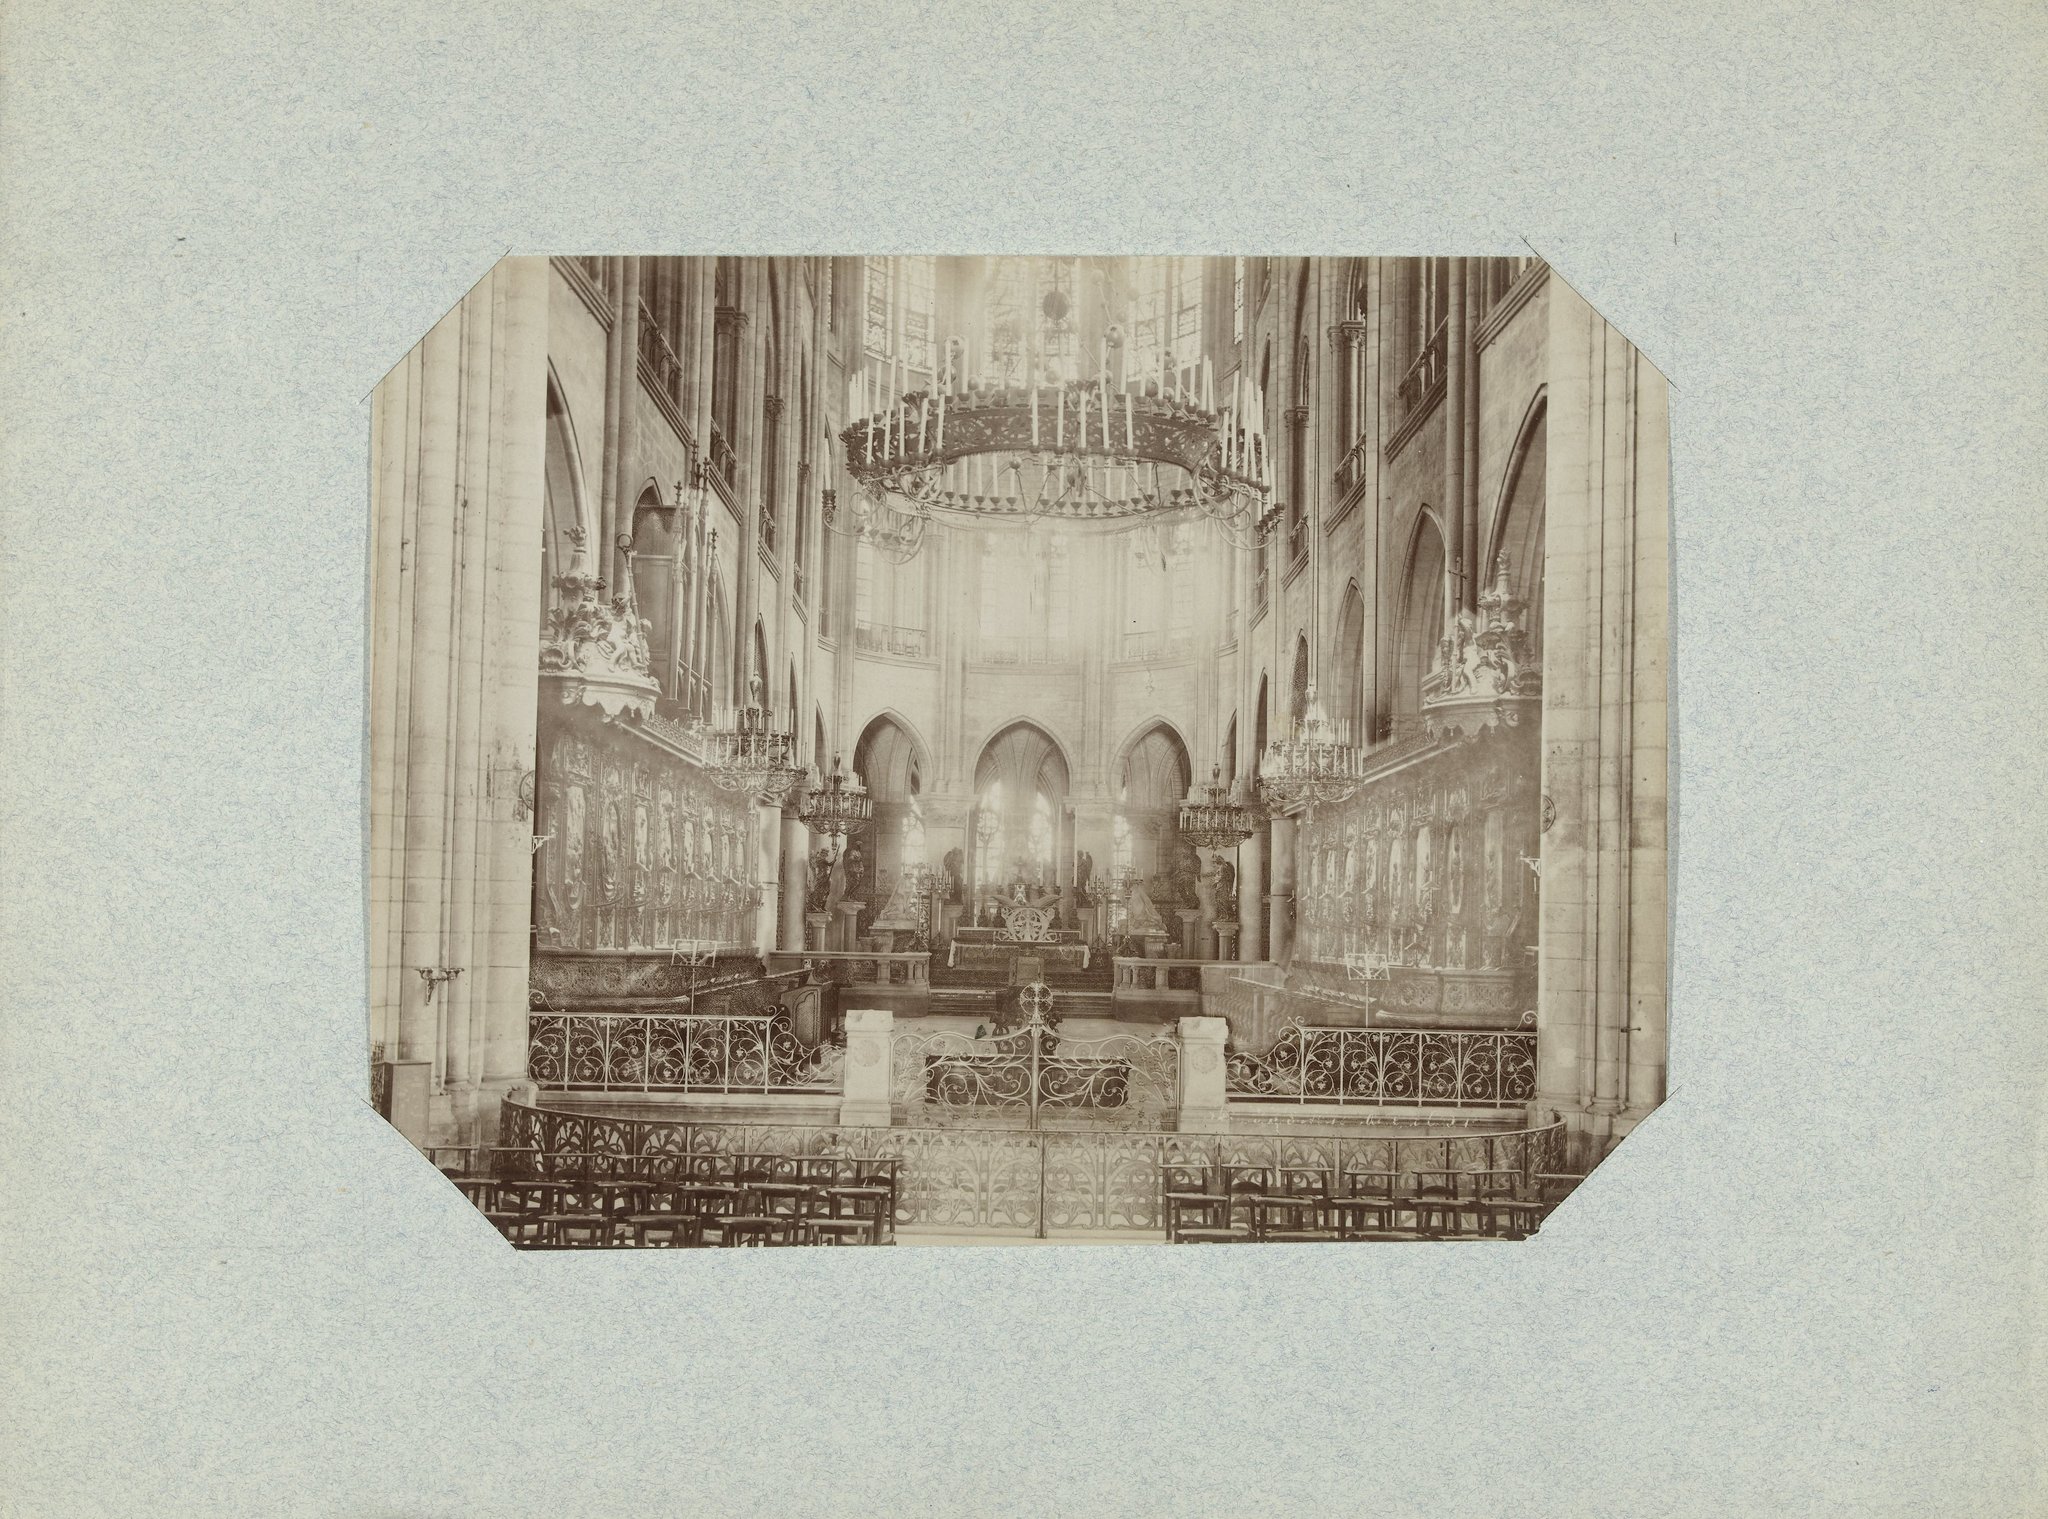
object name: photograph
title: Interieur van het koor in de Notre-Dame in Parijs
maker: Anonymous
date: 1851-1900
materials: cardboard, paper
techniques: albumen print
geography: paris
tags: parts of church interior: choir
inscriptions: stamp: ‘J. RÉSÉGOTTI/ ÉDITEUR/ 8, Rue Vivienne/ [...]’, stamp: ‘14’